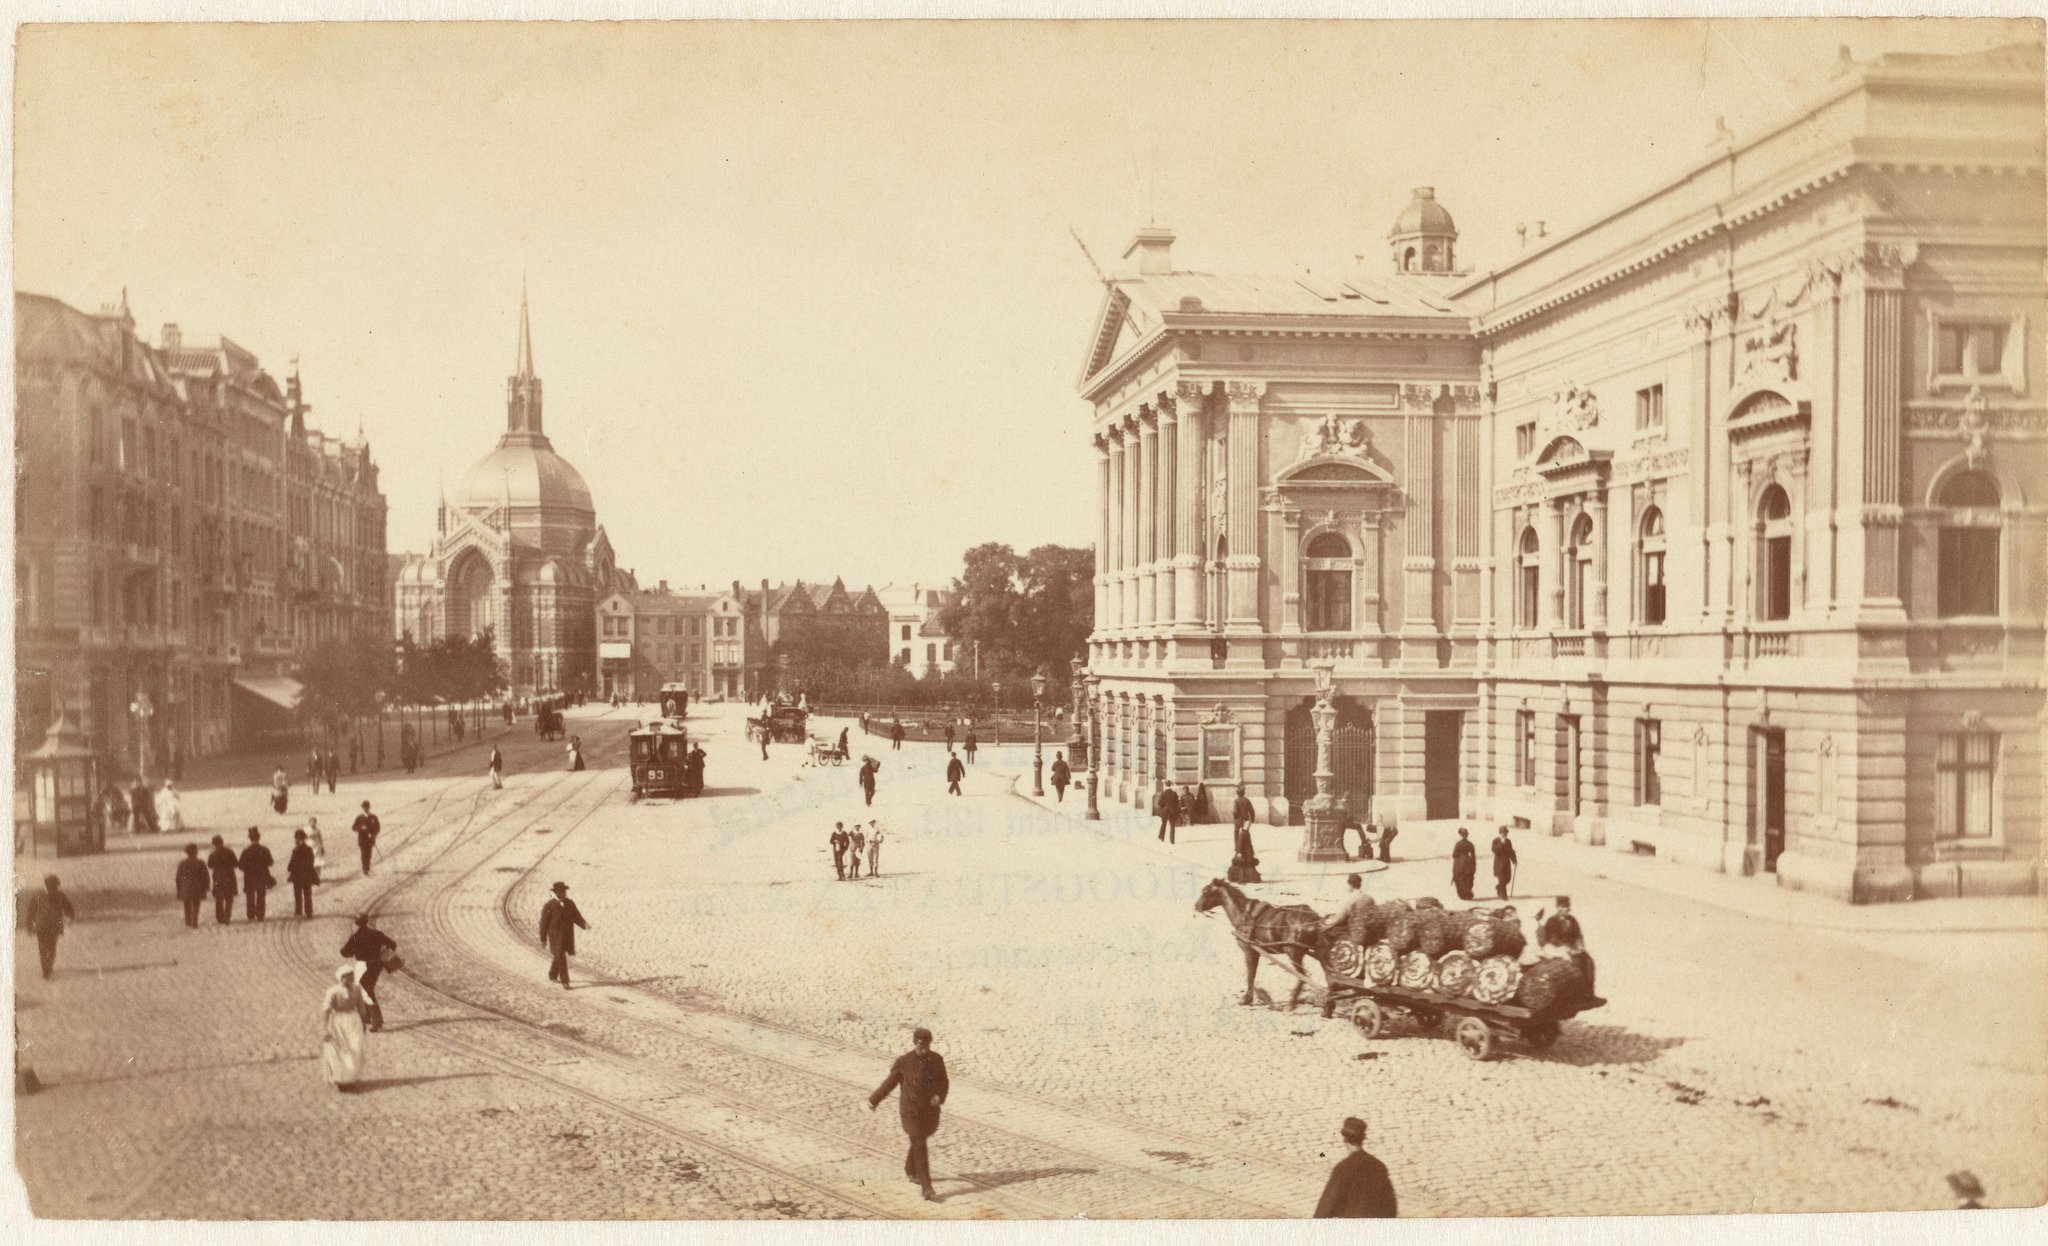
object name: photograph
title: Amsterdam, le Leidscheplein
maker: Anonymous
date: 1860-1890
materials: paper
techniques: albumen print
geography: amsterdam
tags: city-view in general; 'veduta'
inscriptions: retailer's mark: ‘Boek-, Papier- en Kunsthandel./ Opgericht 1813./ A. VAN HOOGSTRATEN & Zn./ Hofleveranciers,/ PLAATS 11, -'s HAGE.’, number: ‘89’